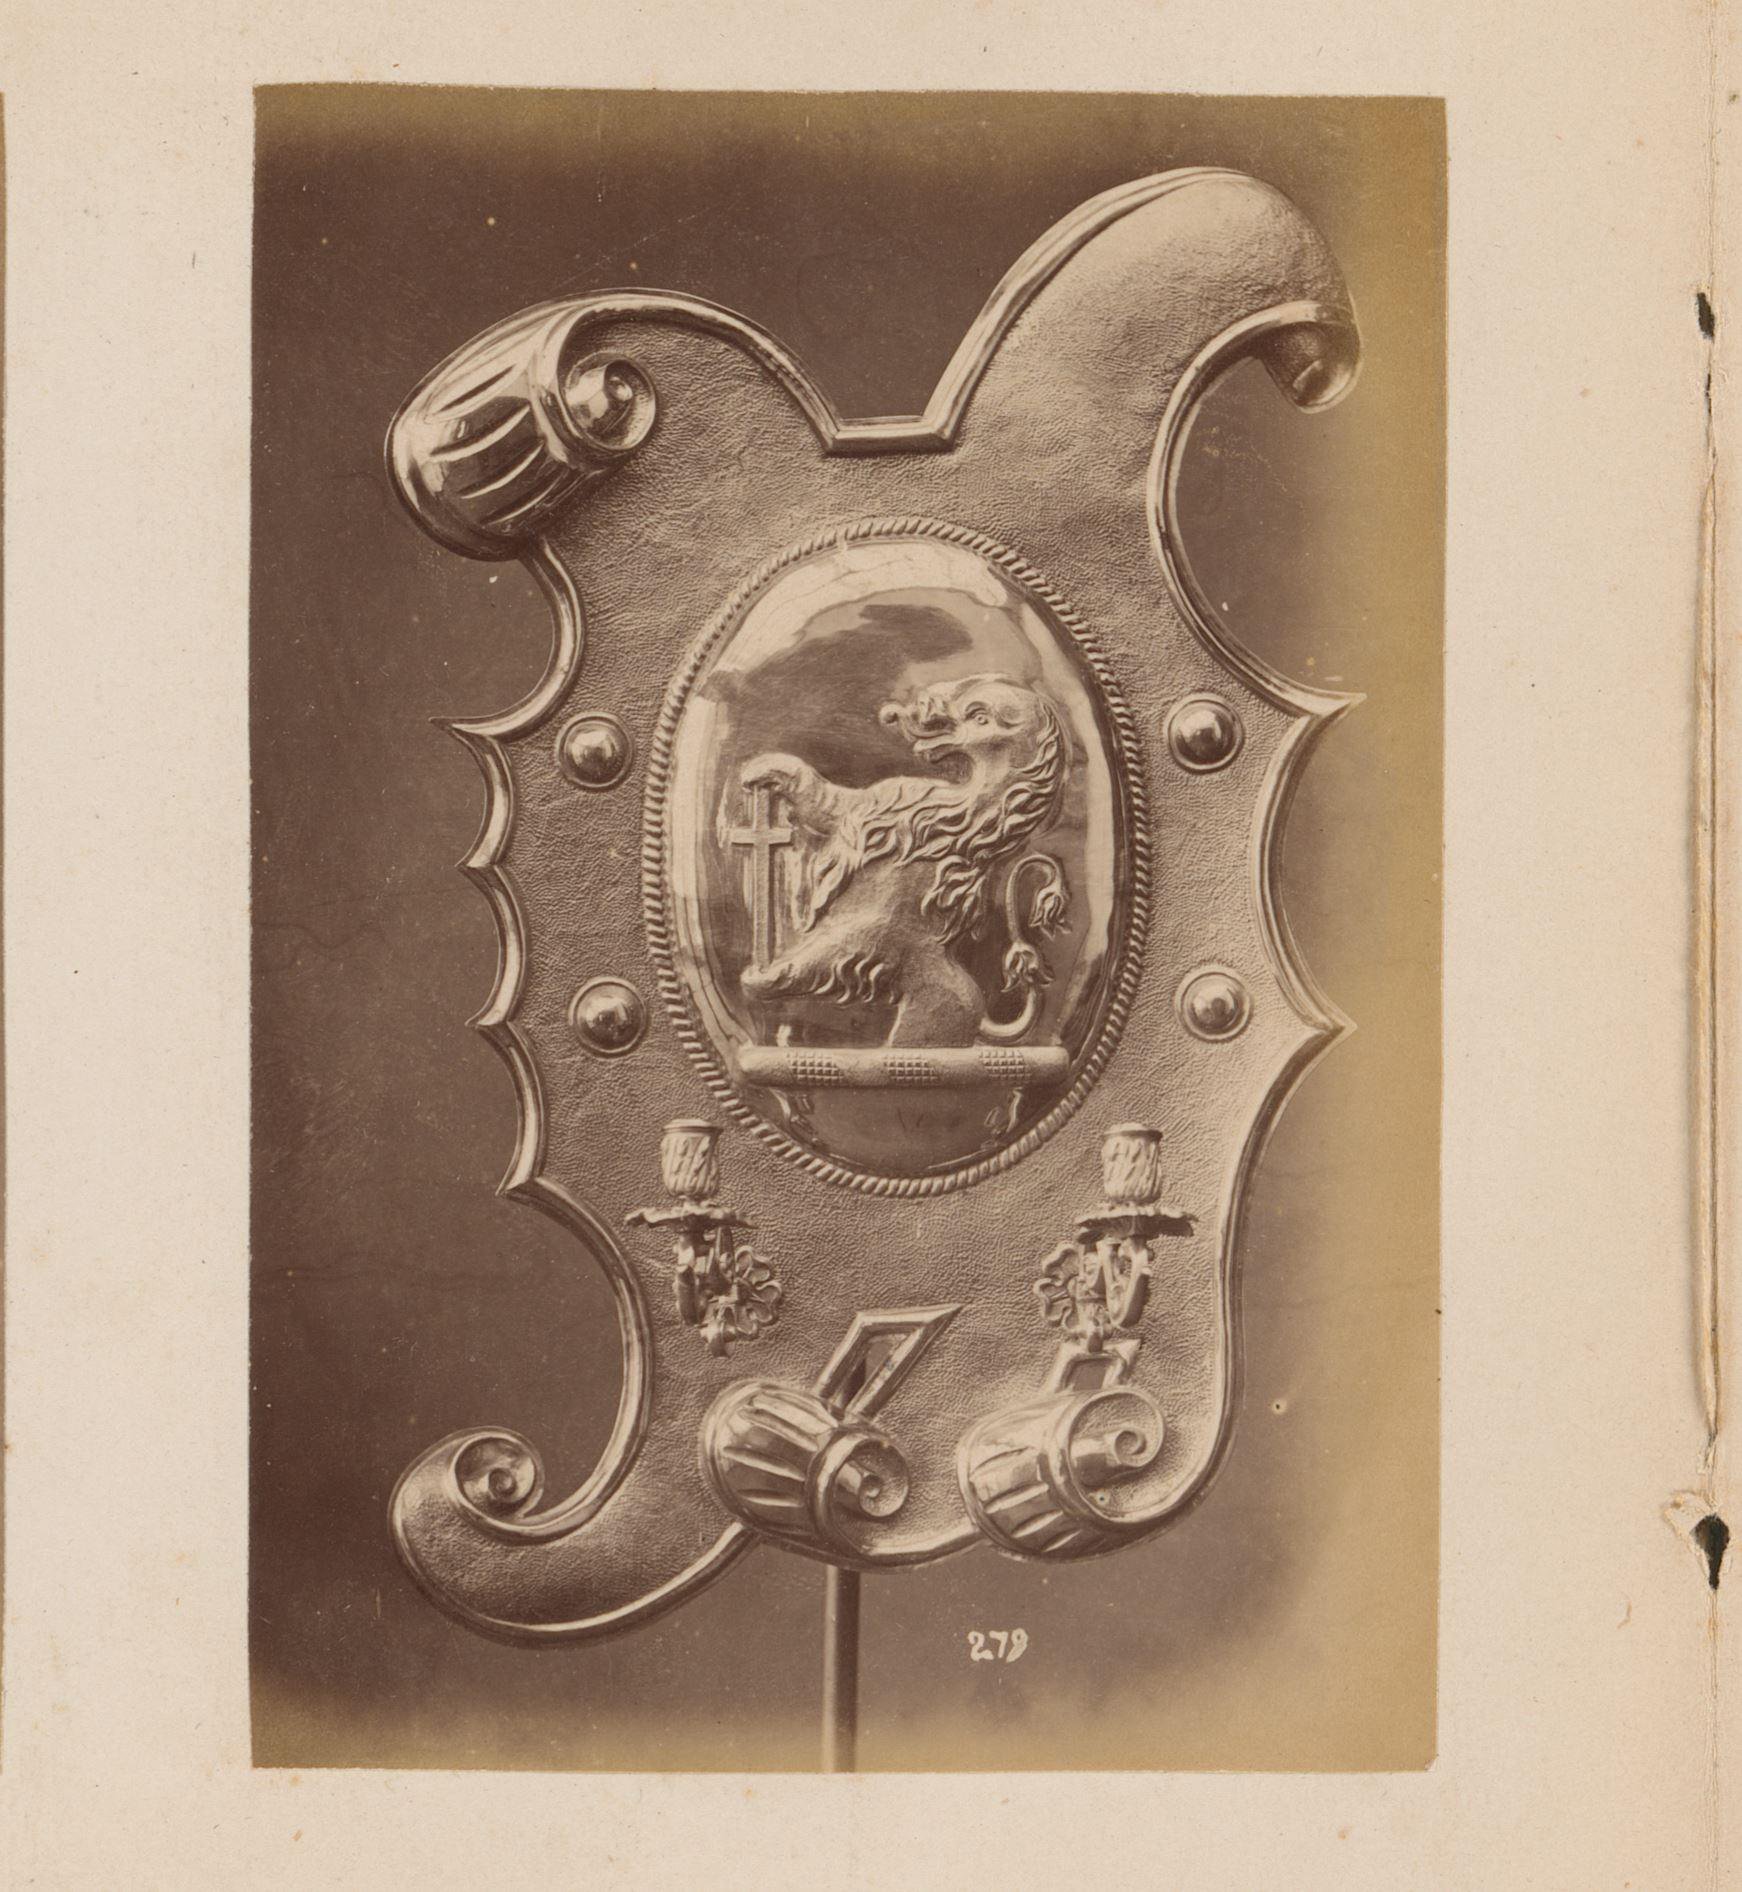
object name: page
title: Metalen wapenschild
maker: Anonymous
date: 1860-1885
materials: photographic support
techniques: albumen print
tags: coat of arms (as symbol of the state, etc.)